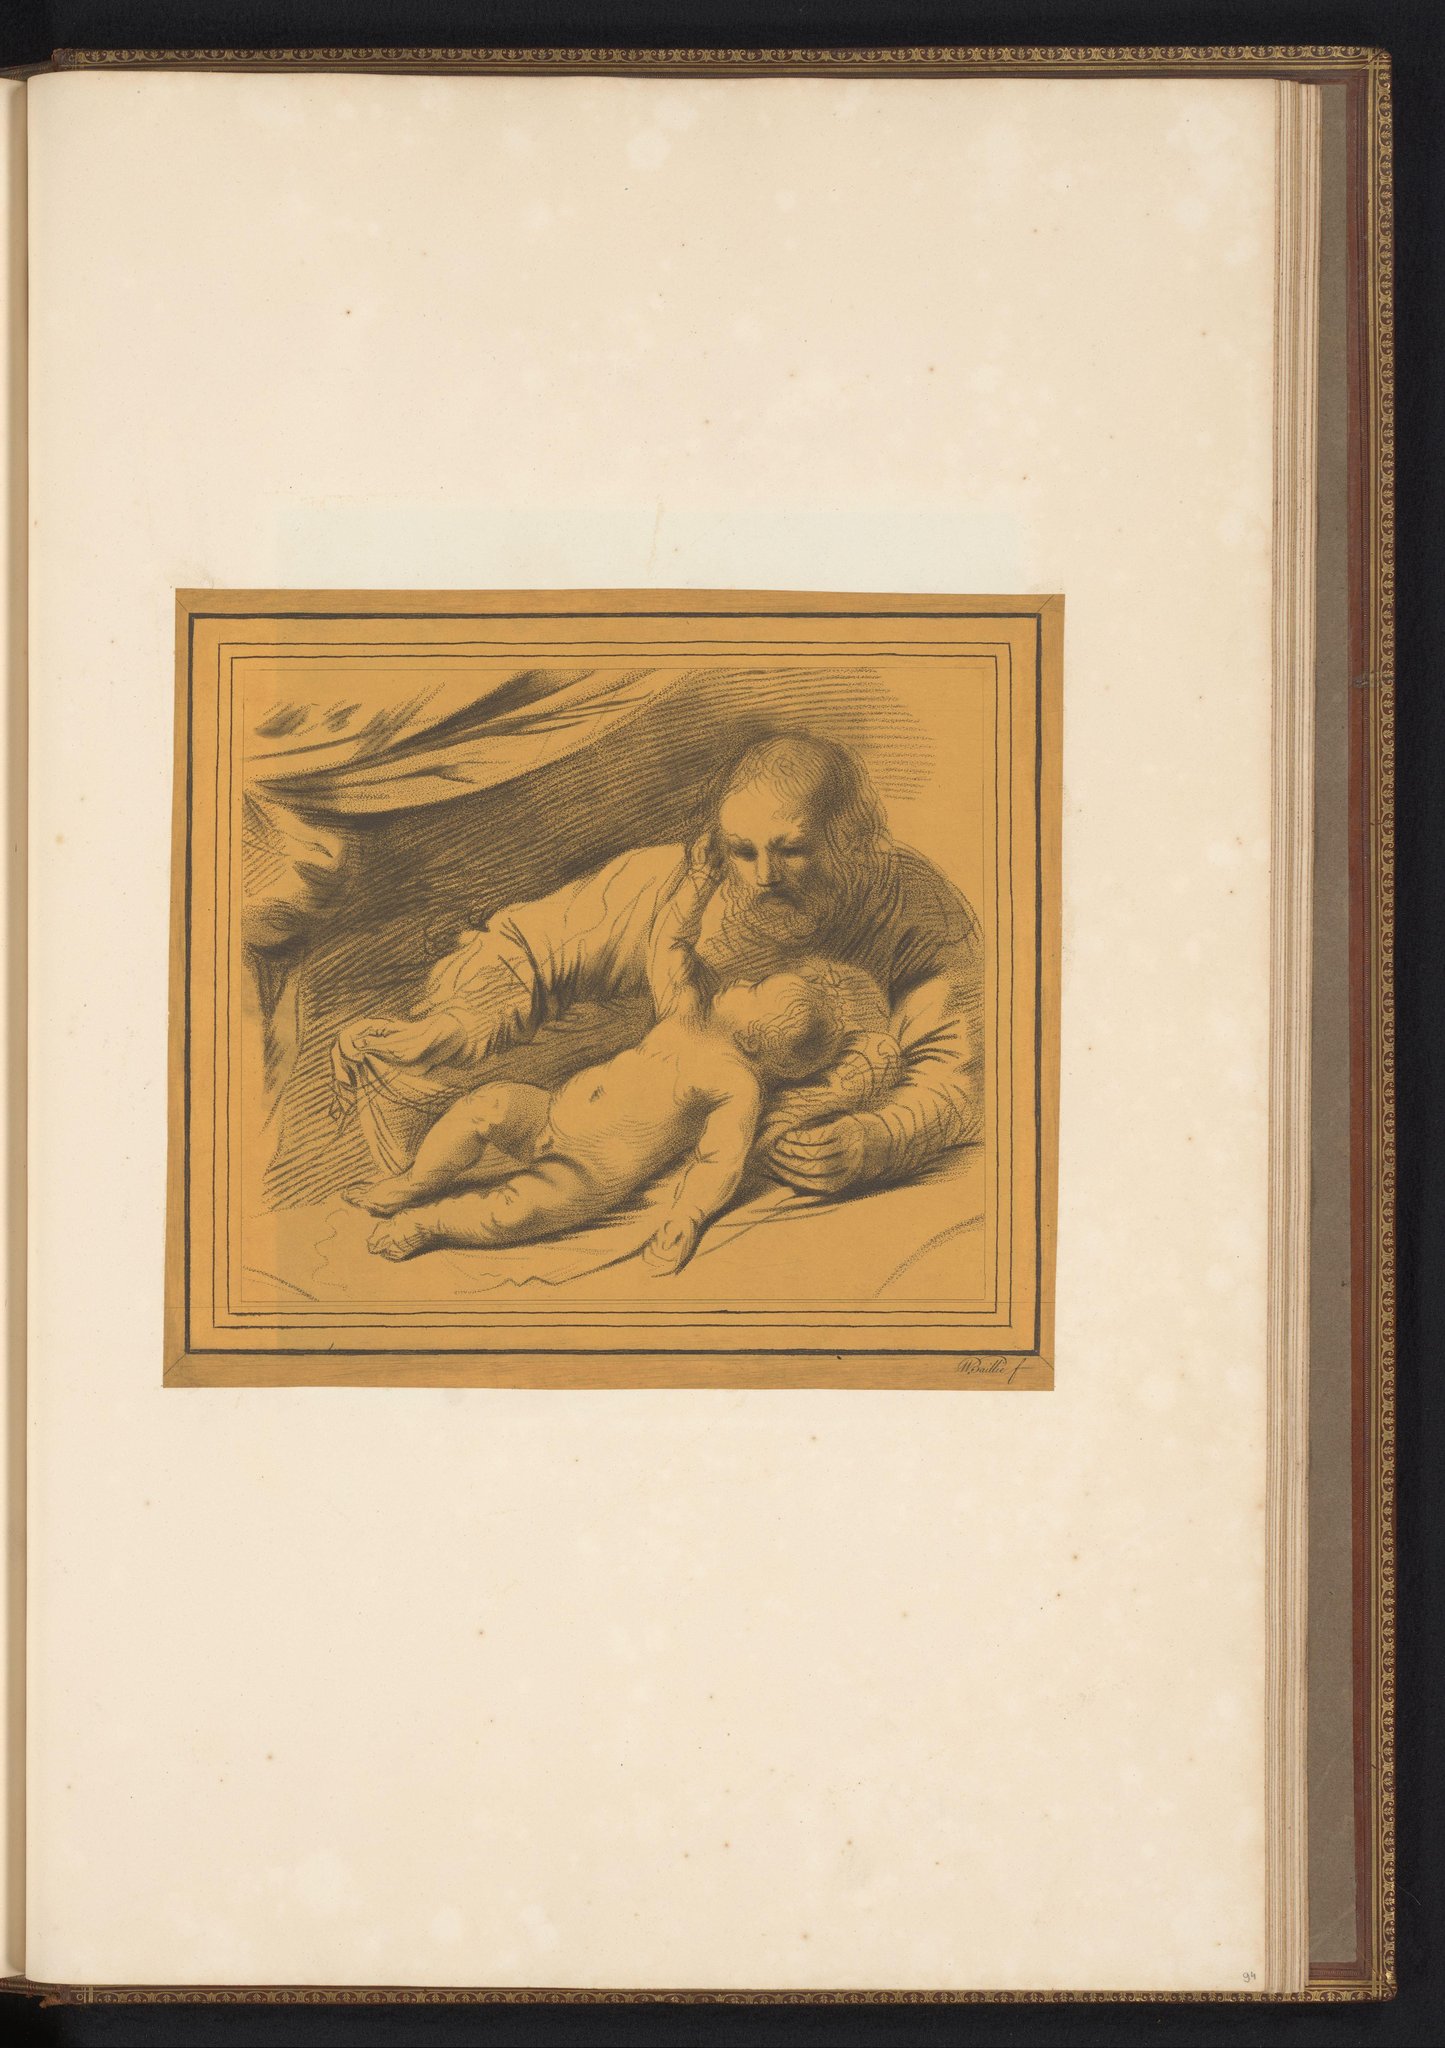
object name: print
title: Jozef en het Christuskind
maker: william baillie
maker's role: print maker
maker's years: 1723-1810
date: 1753-1810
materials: paper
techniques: printmaking, rocker stamped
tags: christ-child together with others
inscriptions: stamp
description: Een kind ligt op een bed en reikt naar het gezicht van de bebaarde man boven hem. De prent maakt deel uit van een album.